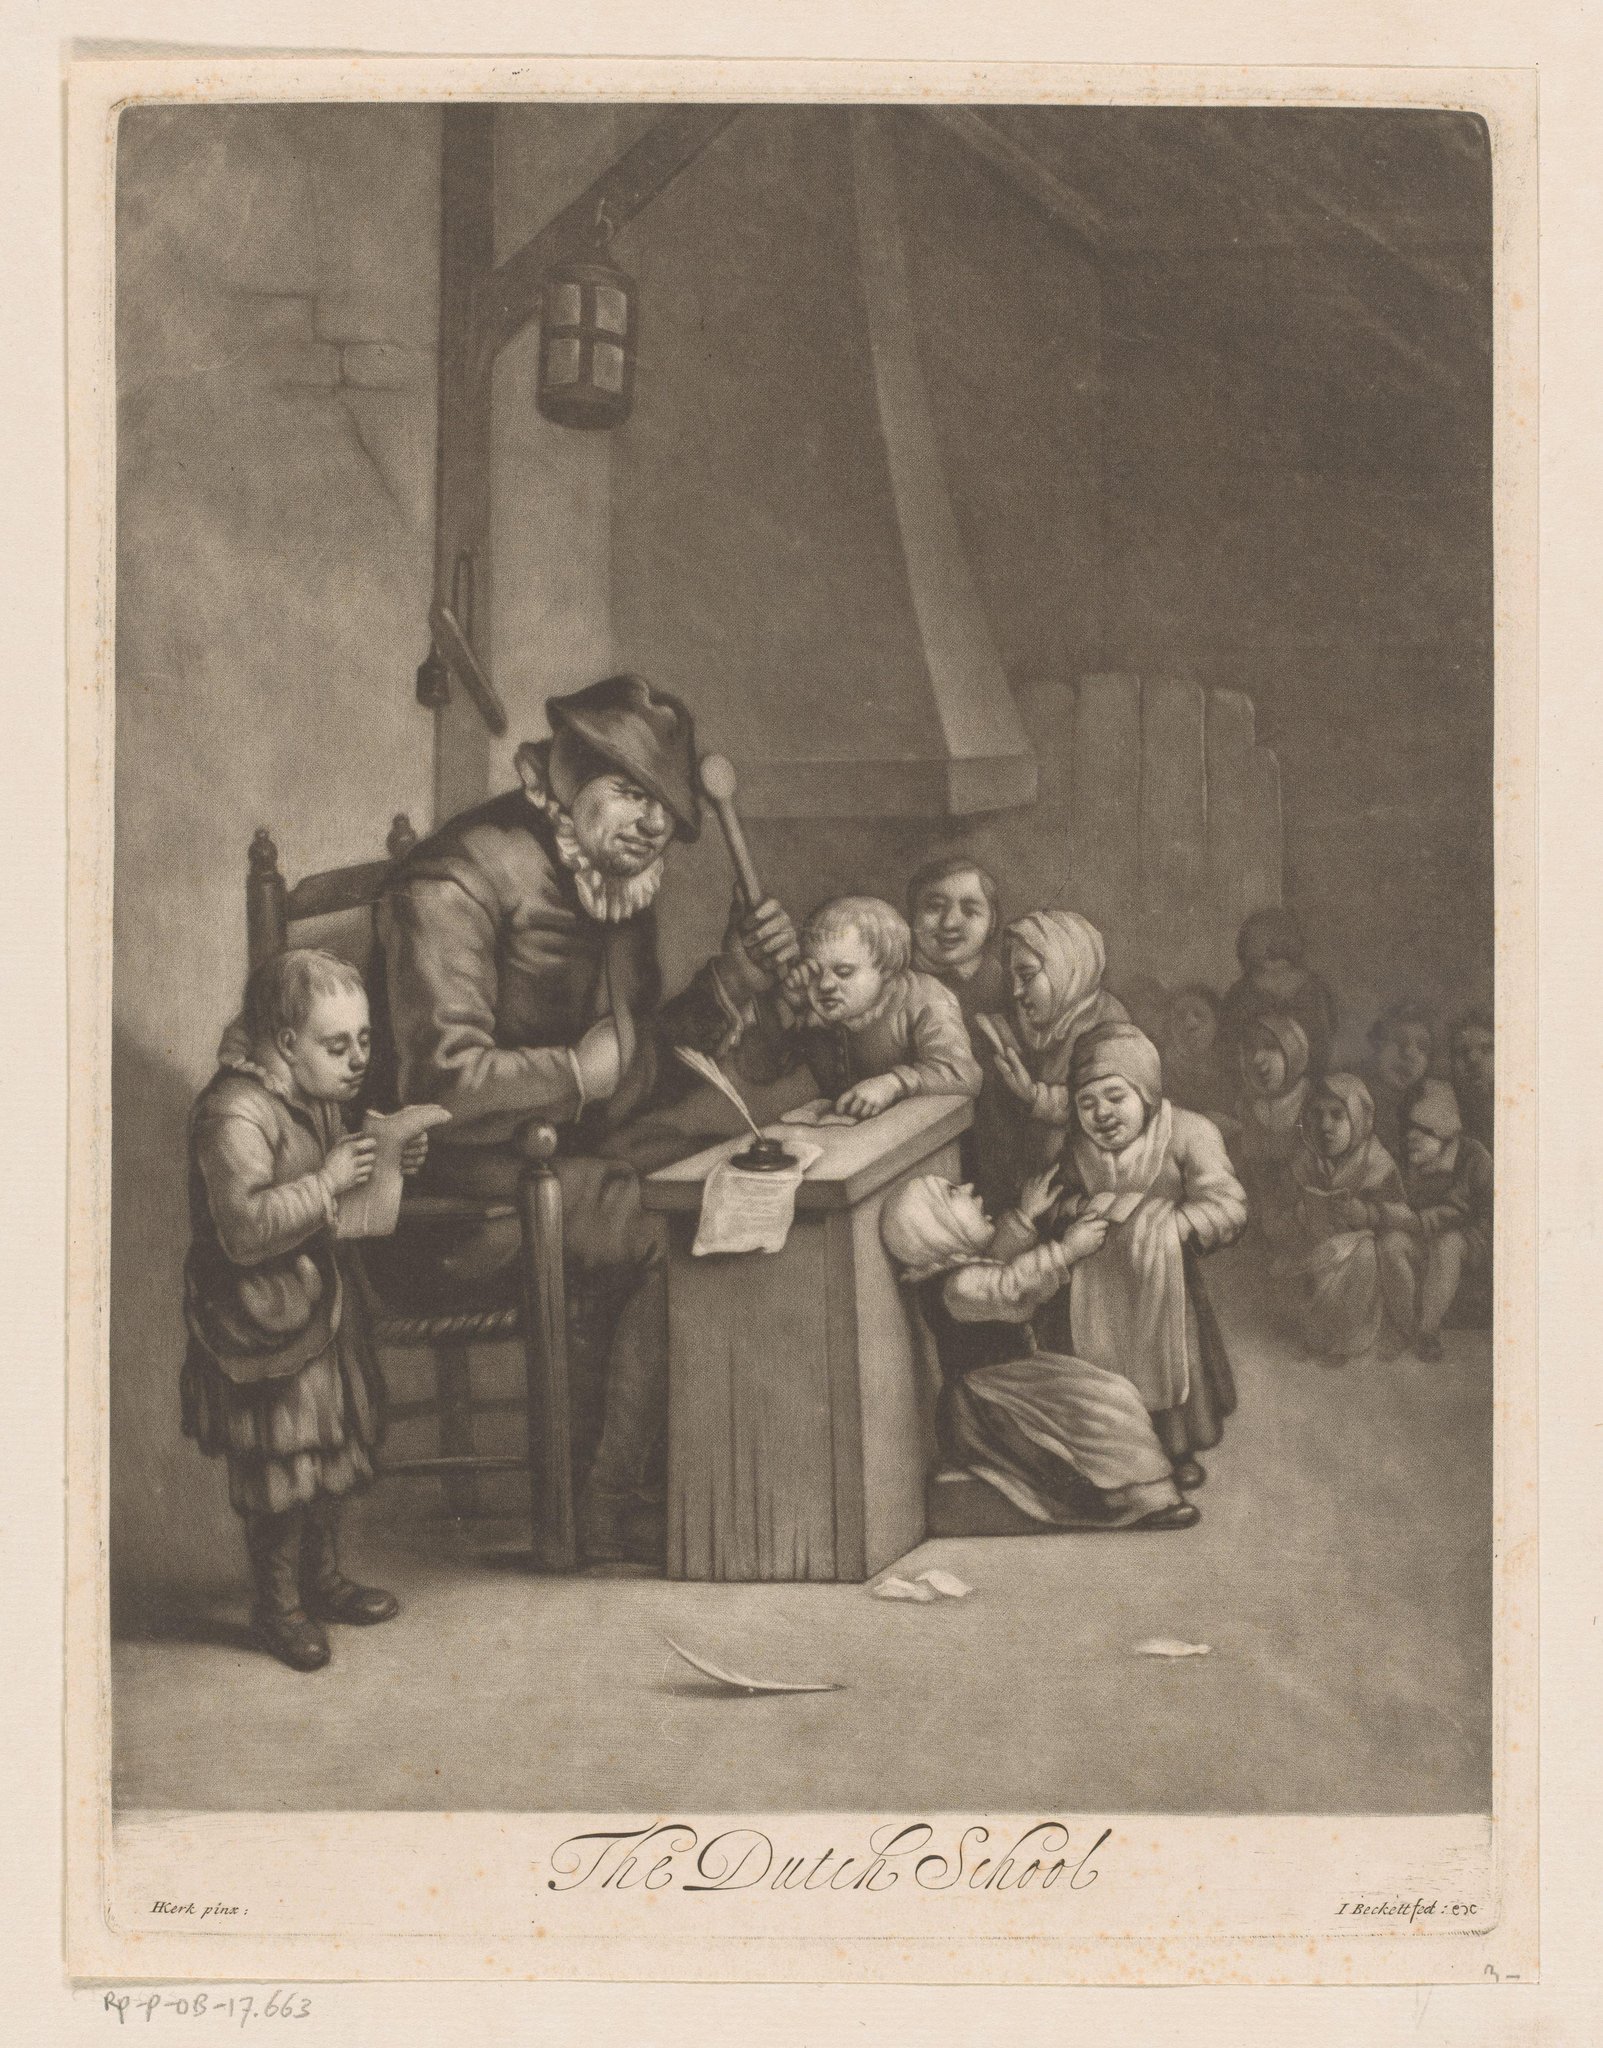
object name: print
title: The Dutch School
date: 1683-1688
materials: paper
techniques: mezzotint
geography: london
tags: teacher and pupil, punishment at school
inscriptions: collector's mark: Lugt 240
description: De meester zit achter een tafel en heeft in zijn linkerhand een houten stok. Naast hem staat een huilende jongen.